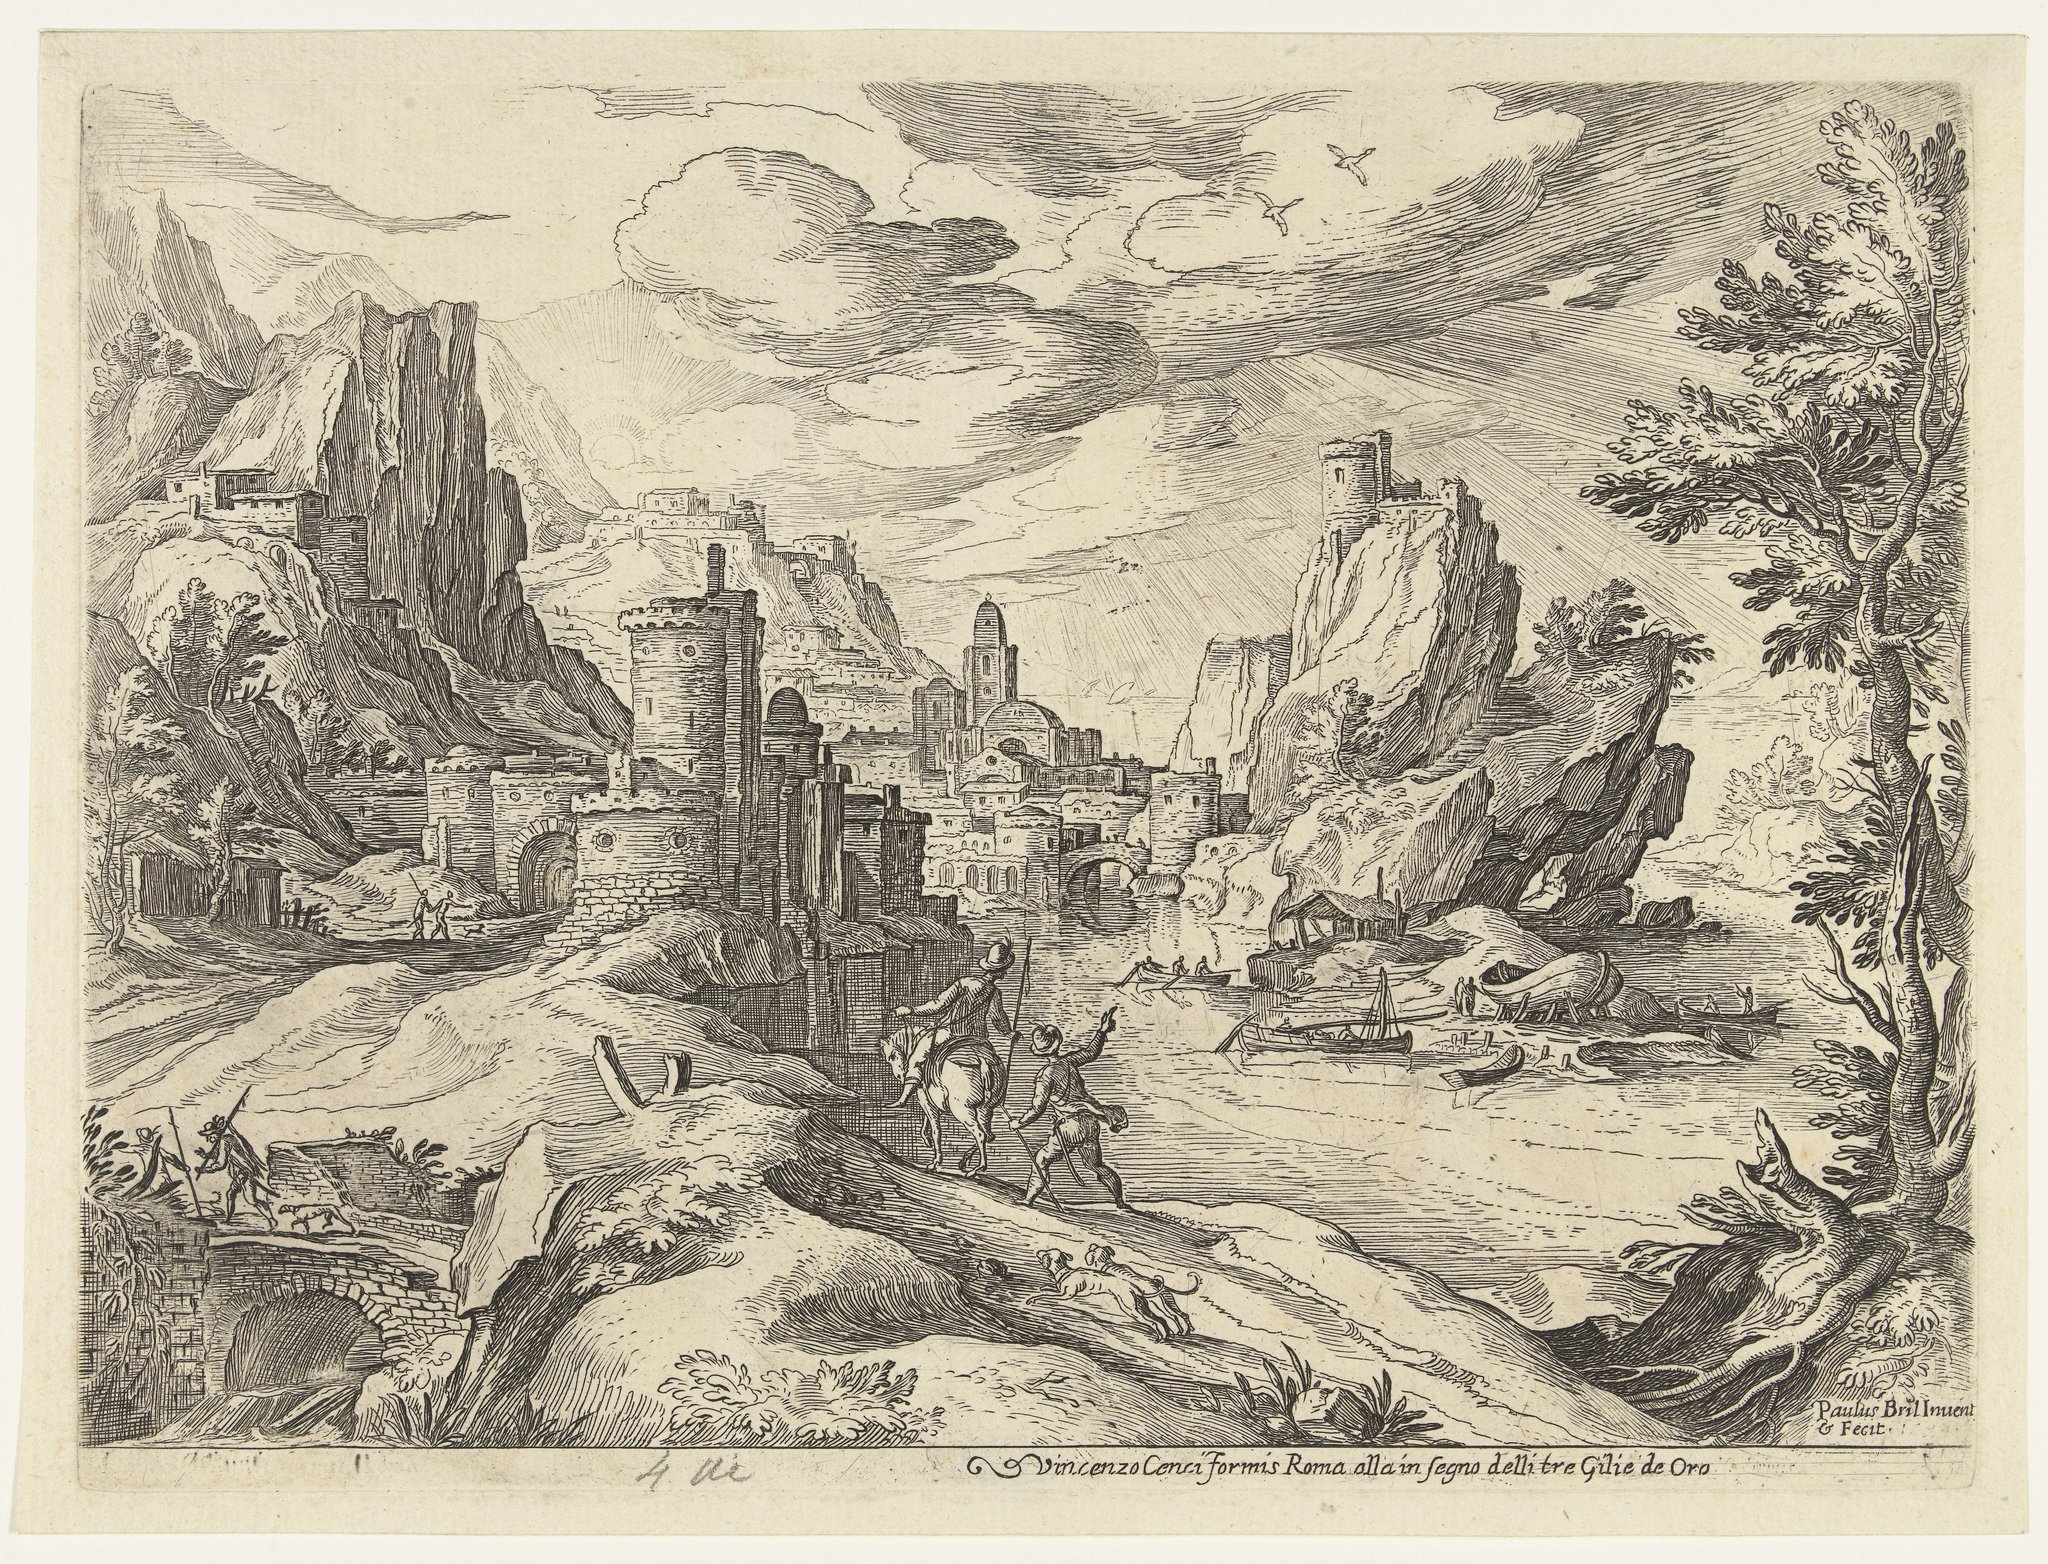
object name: print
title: Rotskust in Campania met stad en reizigers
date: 1590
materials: paper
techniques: etching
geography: rome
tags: rocky coast, 'en route', traveller under way, campania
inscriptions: collector's mark: Lugt 2228a